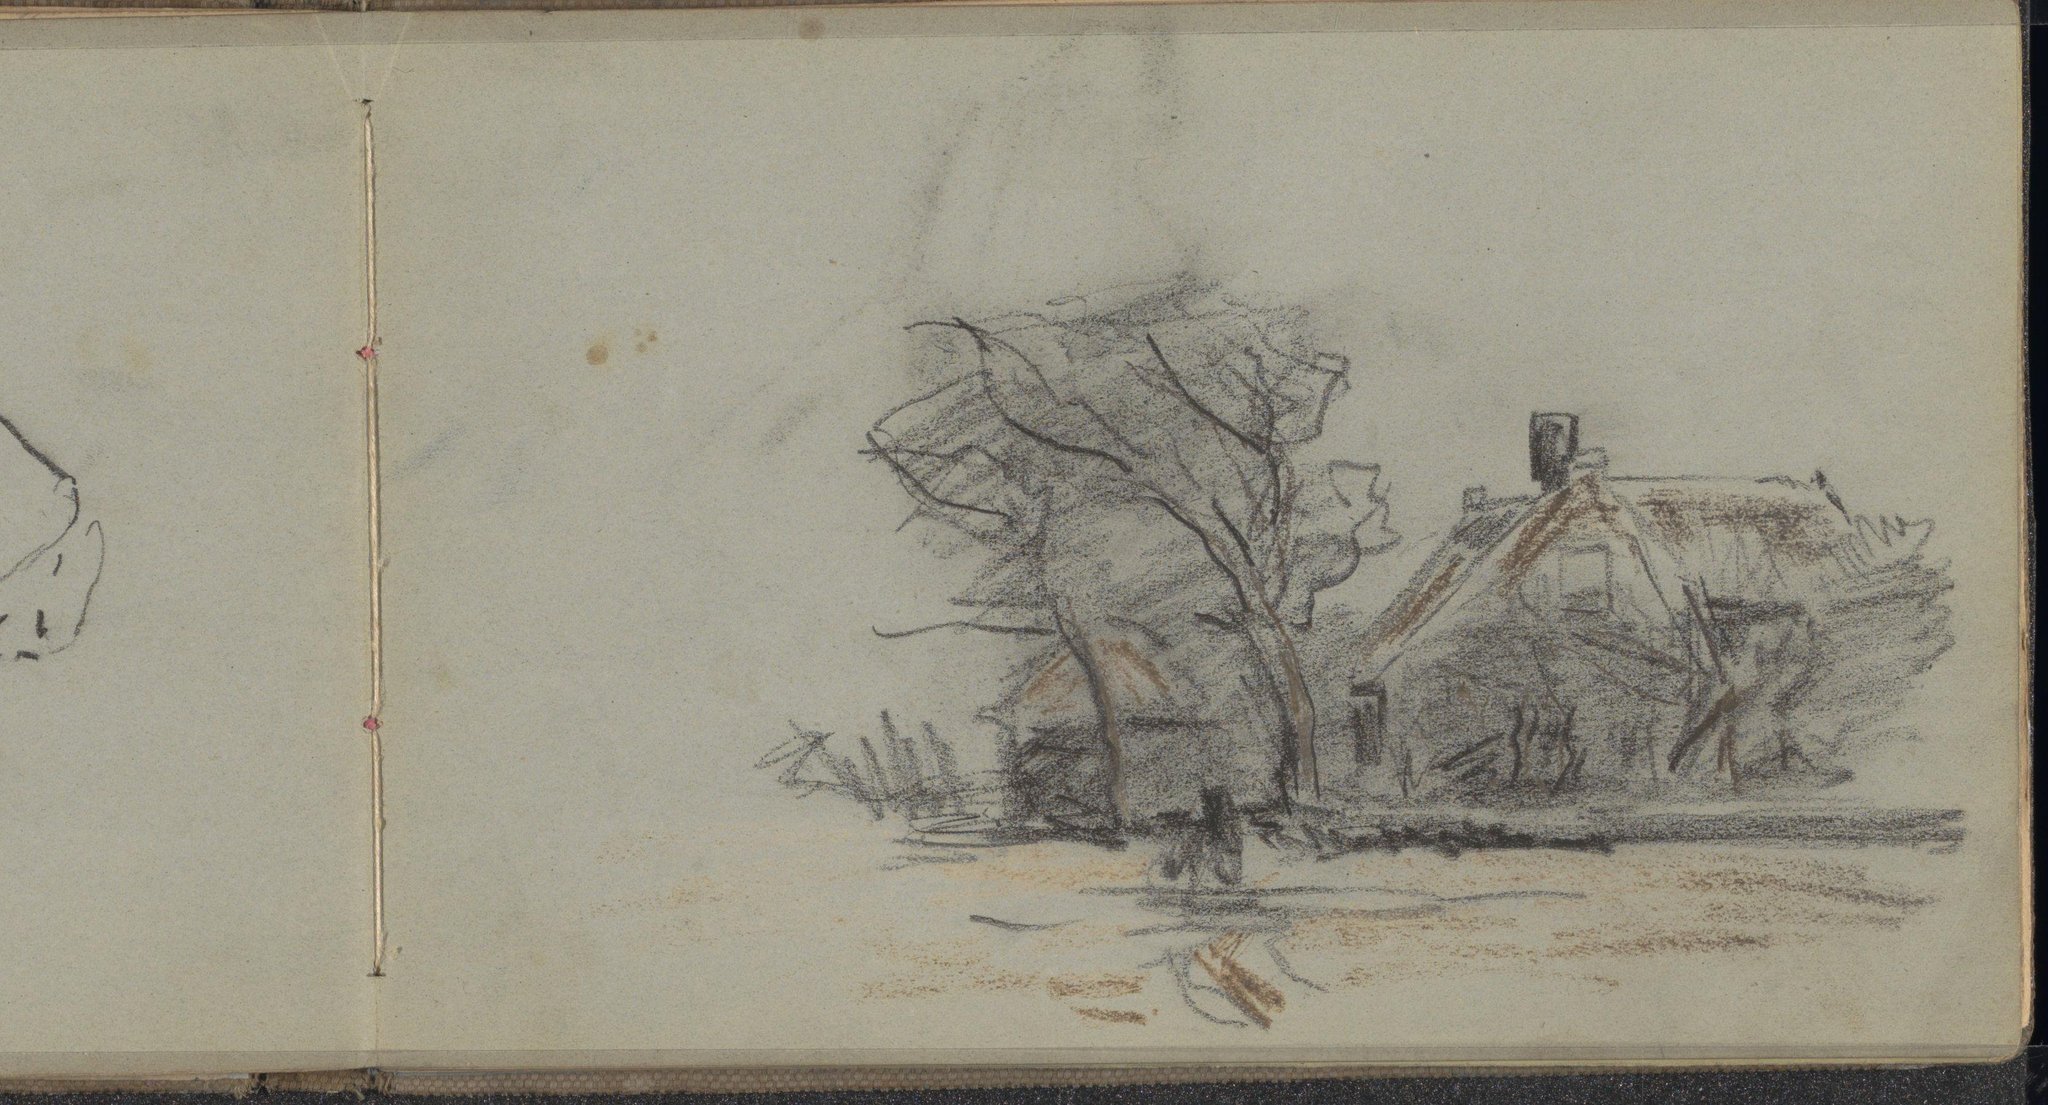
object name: sketchbook leaf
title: Landschap met bebouwing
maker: louis apol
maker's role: draughtsman, painter, print maker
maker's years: 1850-1936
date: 1880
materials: chalk, paper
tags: landscapes, civic architecture; edifices; dwellings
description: Blad 23 recto uit een schetsboek met 38 bladen betekend tijdens de expeditie naar Nova Zembla in 1880.